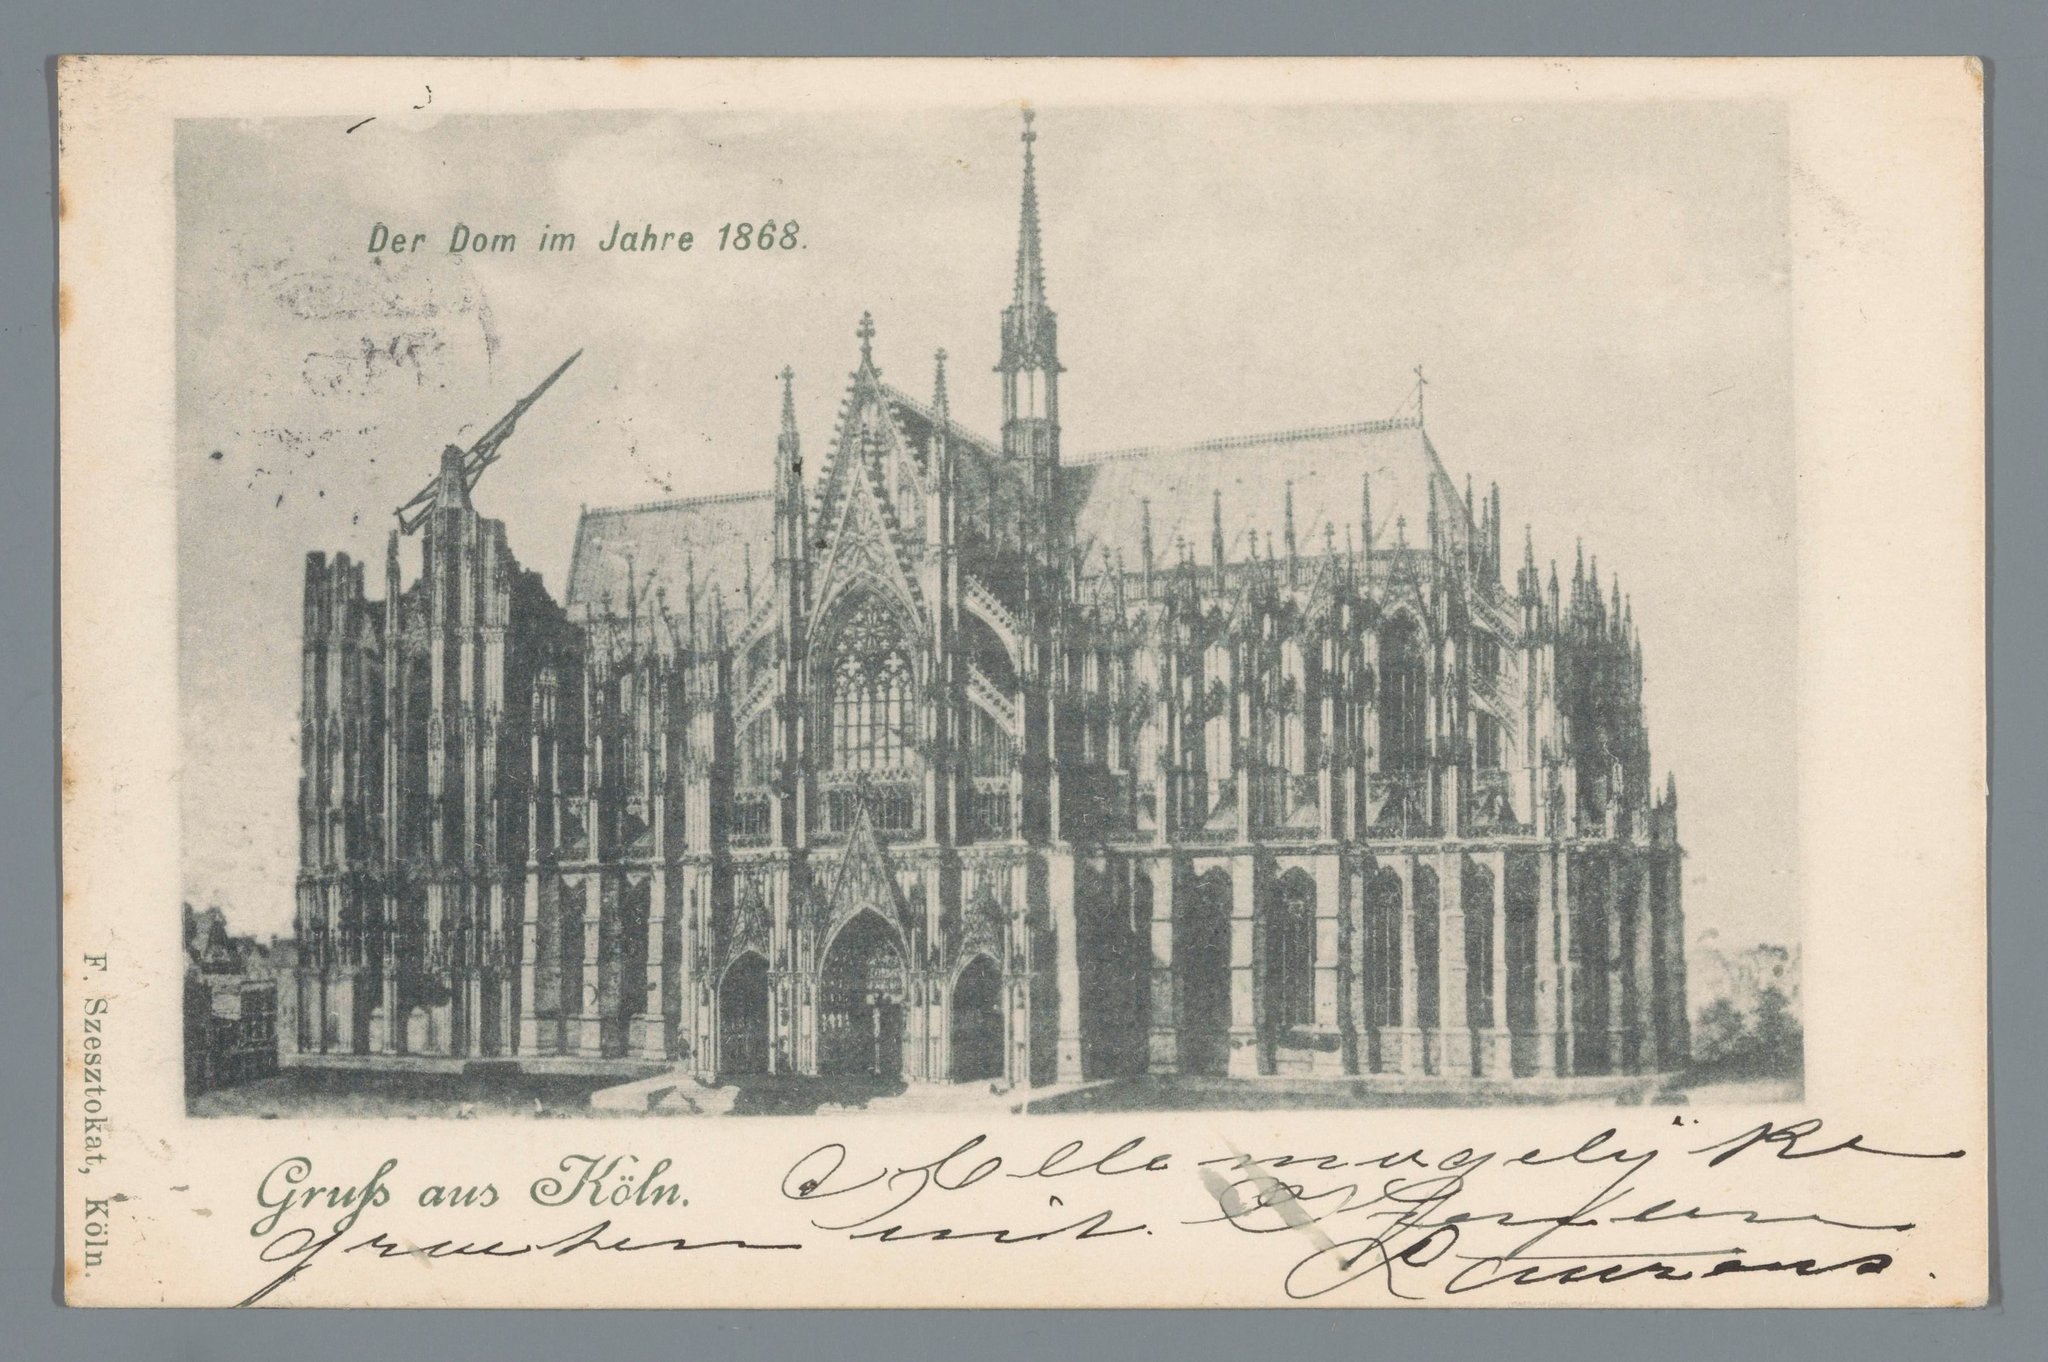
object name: ansichtkaart, prentbriefkaart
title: Gruss aus Köln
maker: f. szesztokat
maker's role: fotograaf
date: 1909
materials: cardboard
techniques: photograph, writing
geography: cologne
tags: church (exterior)